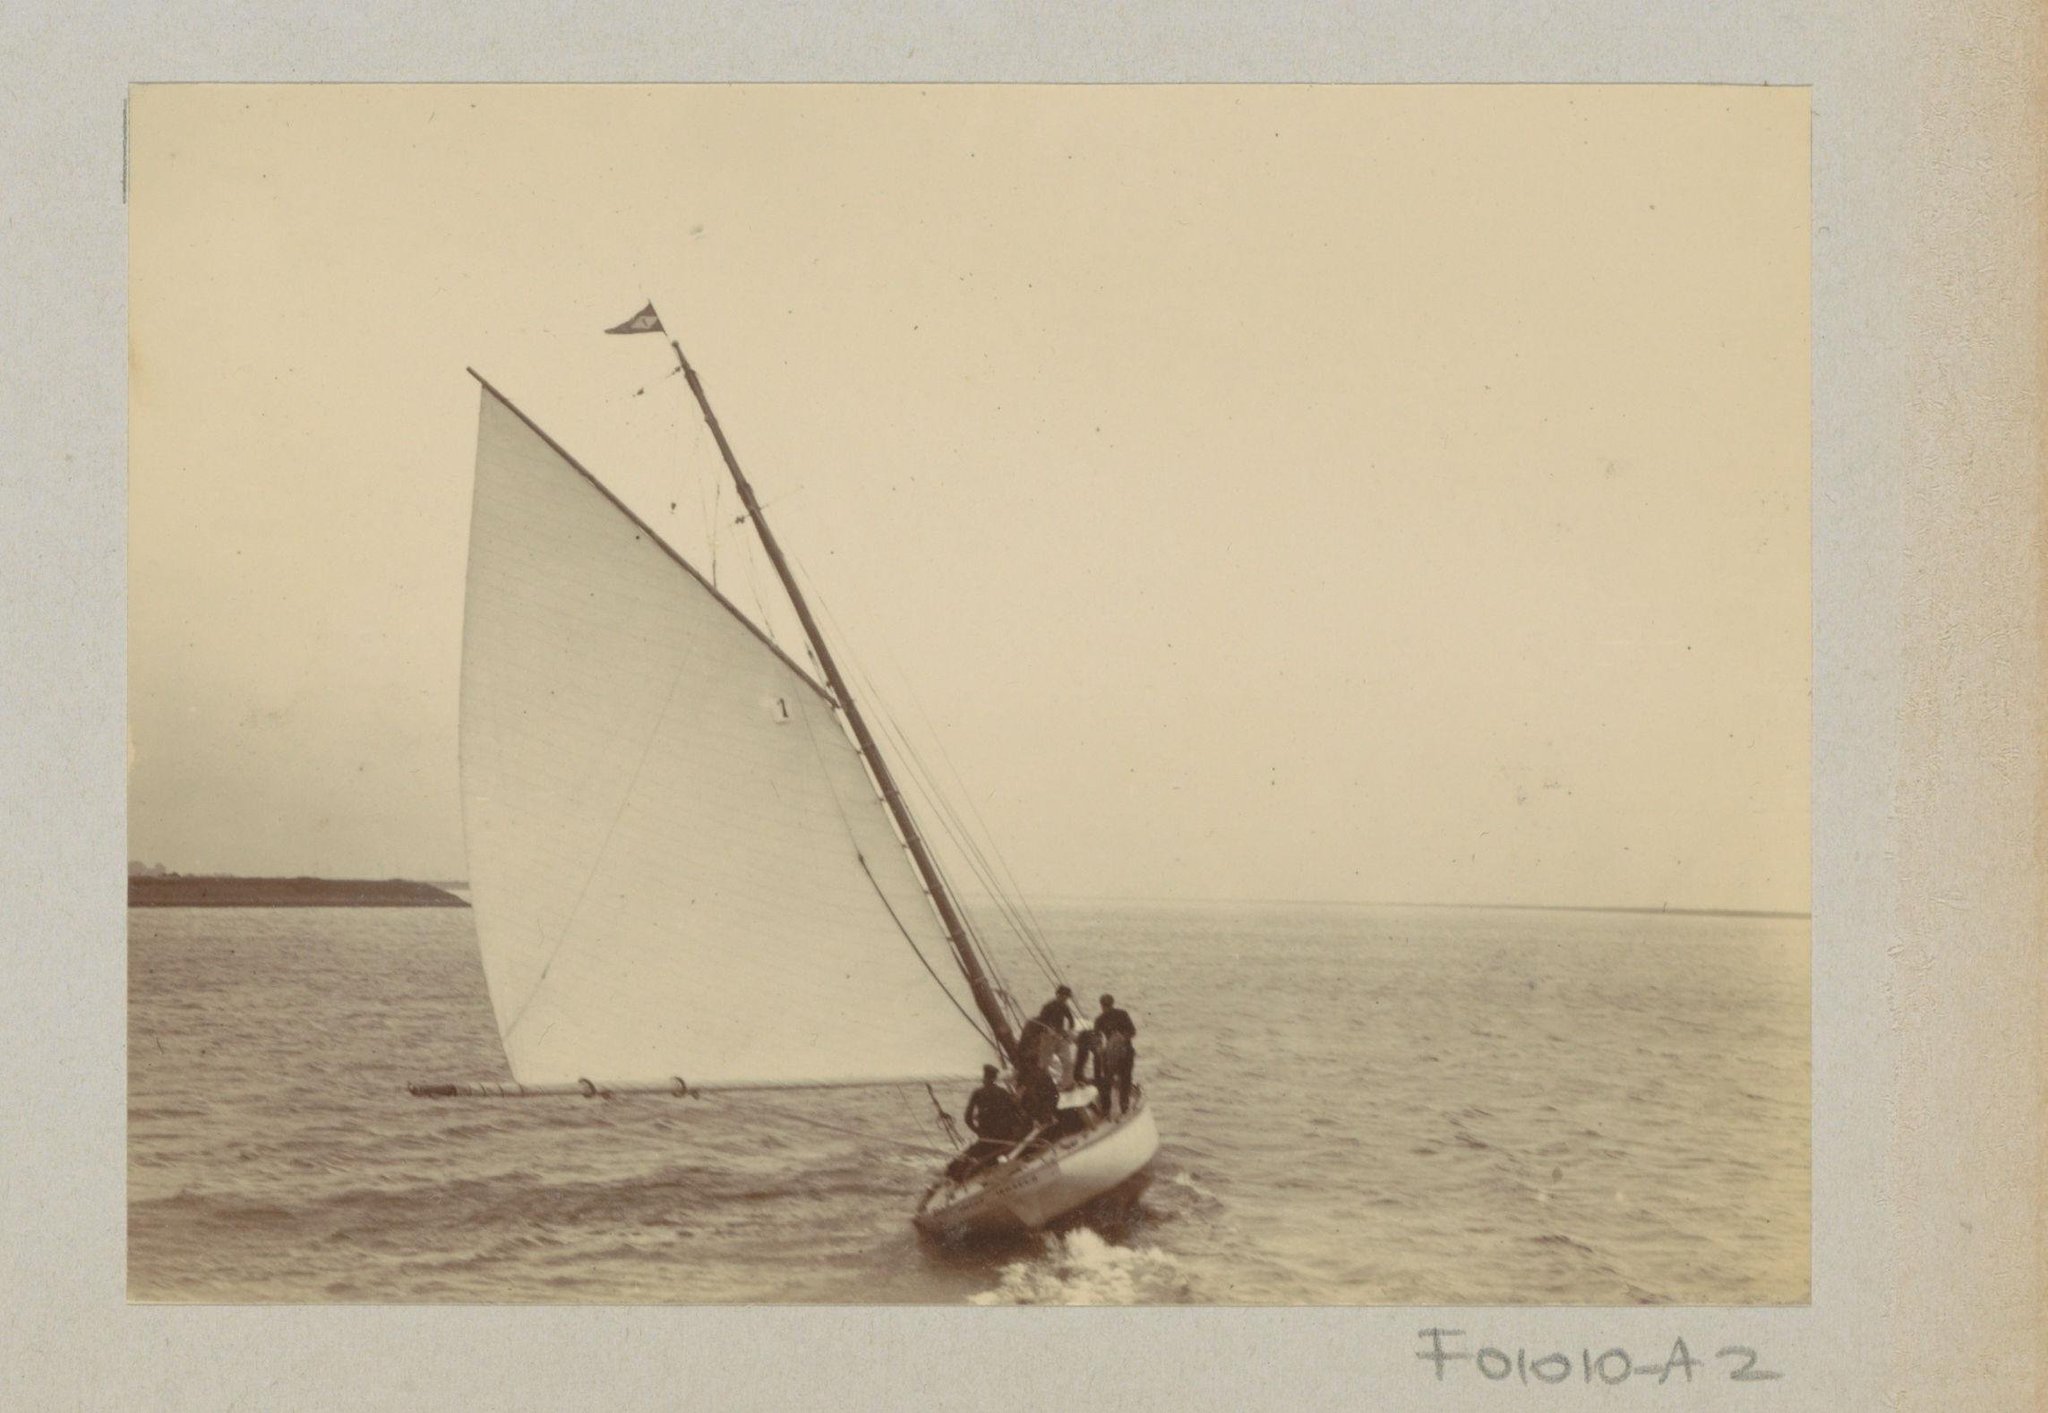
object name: photograph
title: Zeilschip op het water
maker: Anonymous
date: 1900-1910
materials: photographic support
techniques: daylight paper print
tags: sailing-ship, sailing-boat, sea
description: Onderdeel van Familiealbum met onder meer foto's van Wijnhandel Kraaij & Co. Bordeaux-Amsterdam.